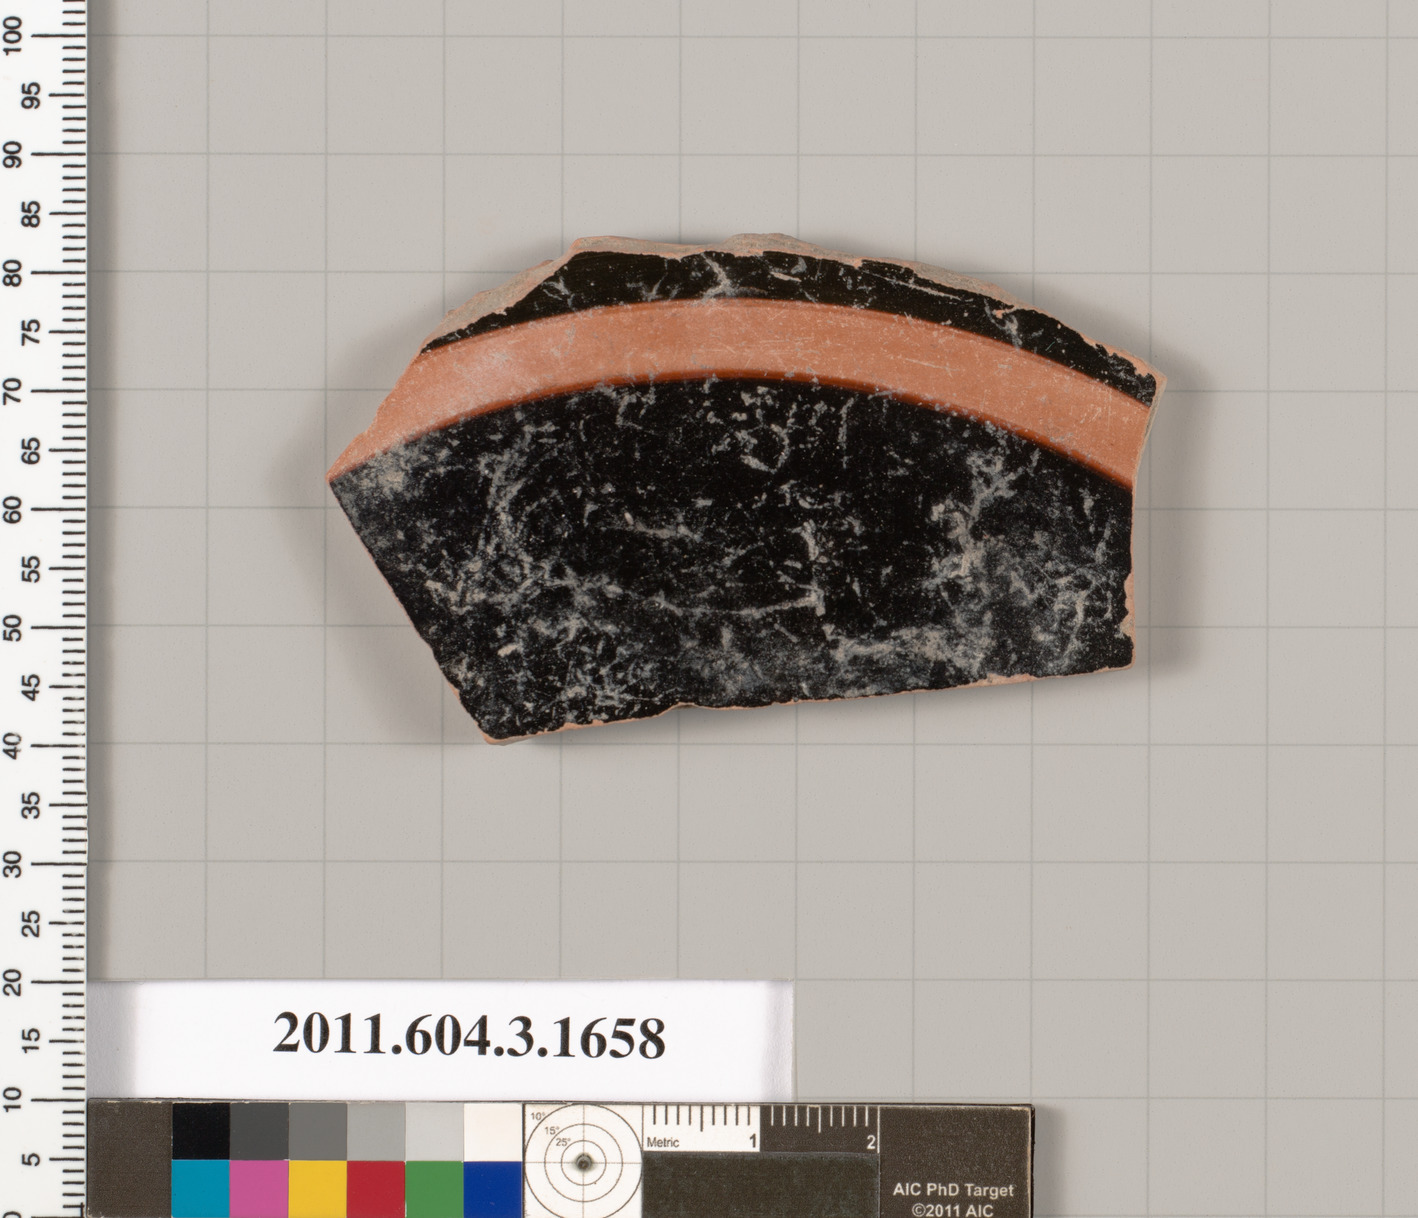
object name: kylix fragment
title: Terracotta fragment of a kylix: Band or lip cup (drinking cup)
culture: greek, attic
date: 550-526 BCE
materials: terracotta